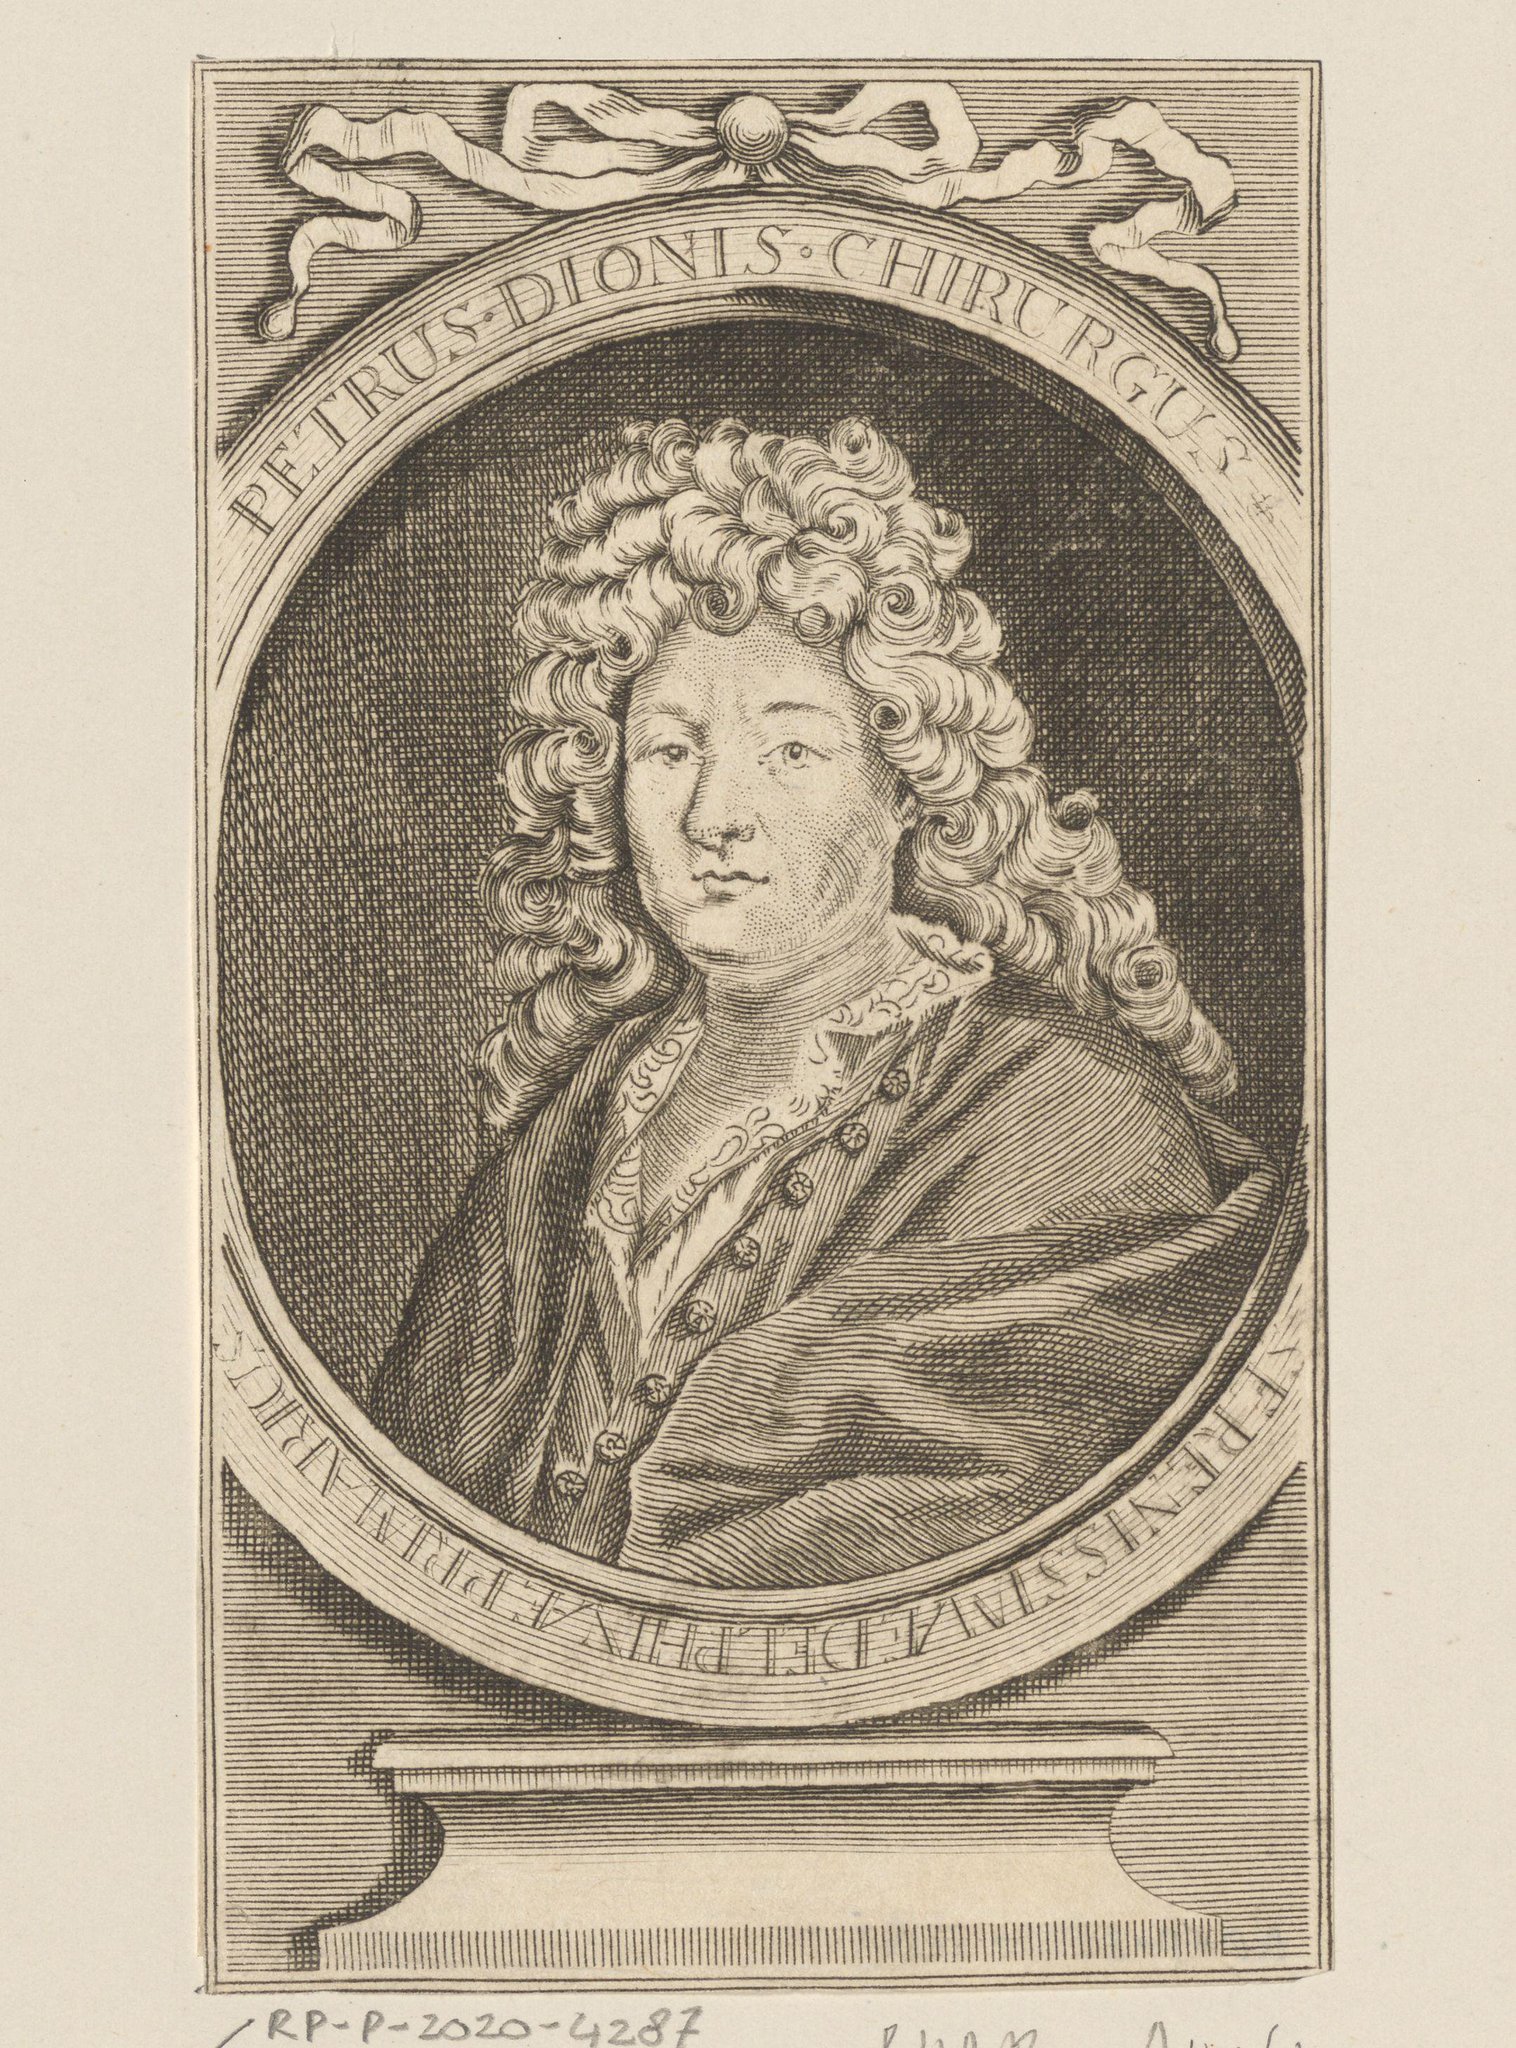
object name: print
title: Portret van Pierre Dionis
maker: Anonymous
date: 1672-1750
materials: paper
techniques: engraving, etching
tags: historical persons, barber; surgeon